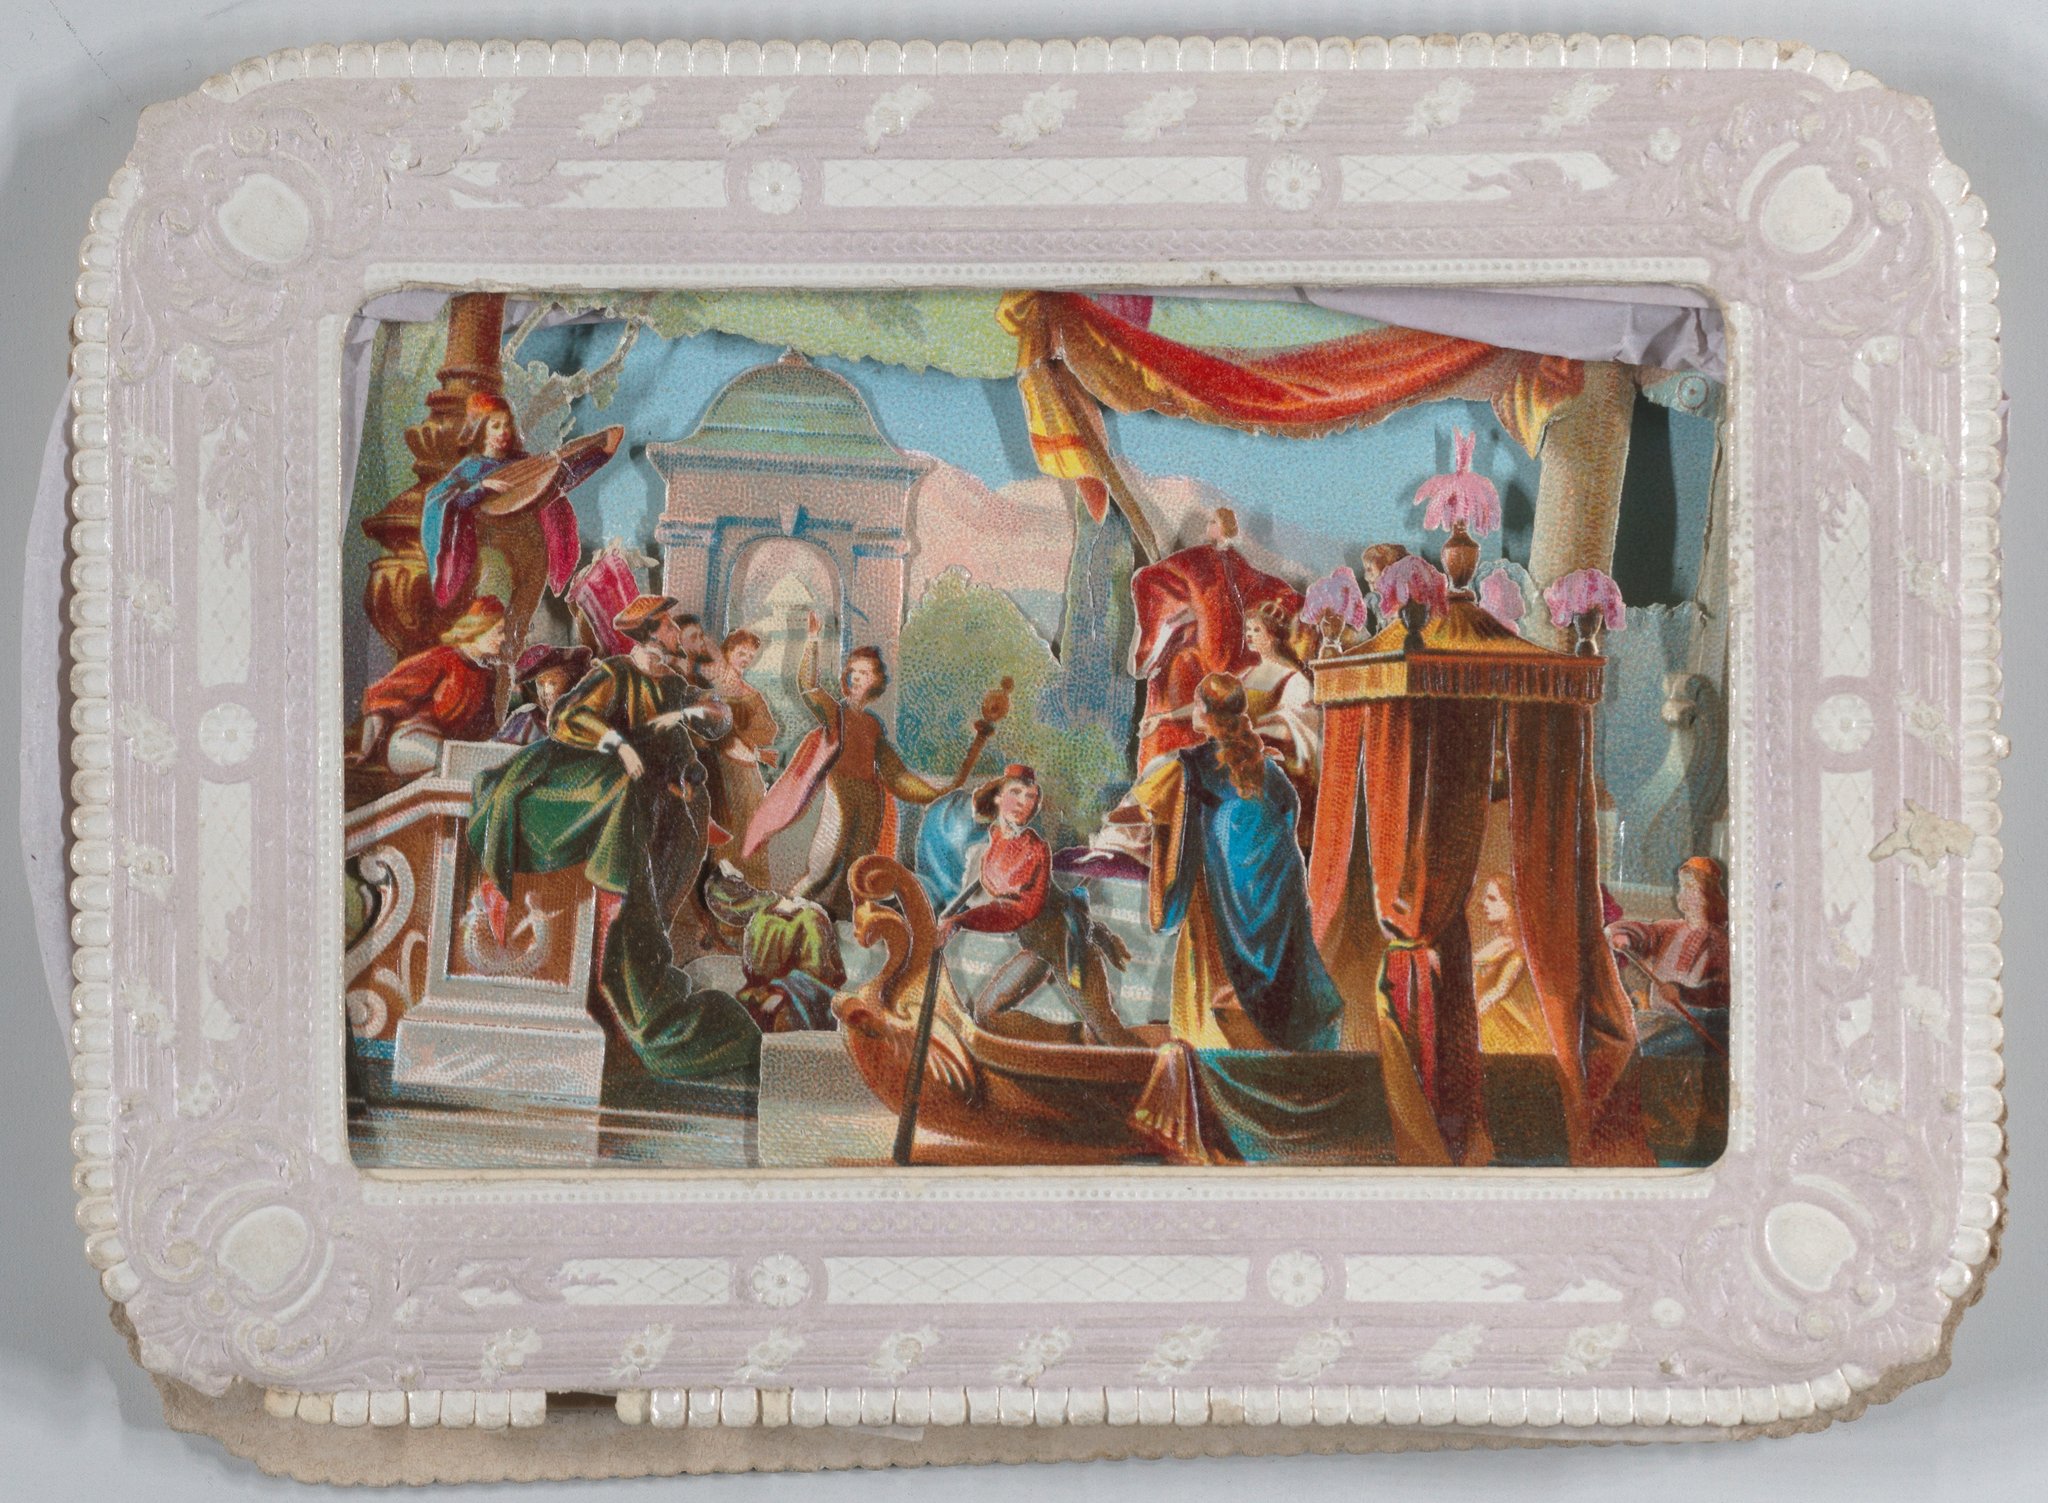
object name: valentine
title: Valentine - Mechanical - scene of barge, troubadours, Temple of Hymen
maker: anonymous, german, 19th century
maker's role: artist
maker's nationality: german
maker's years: 1800-1899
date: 1875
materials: paper, ribbon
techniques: chromolithography, cutting